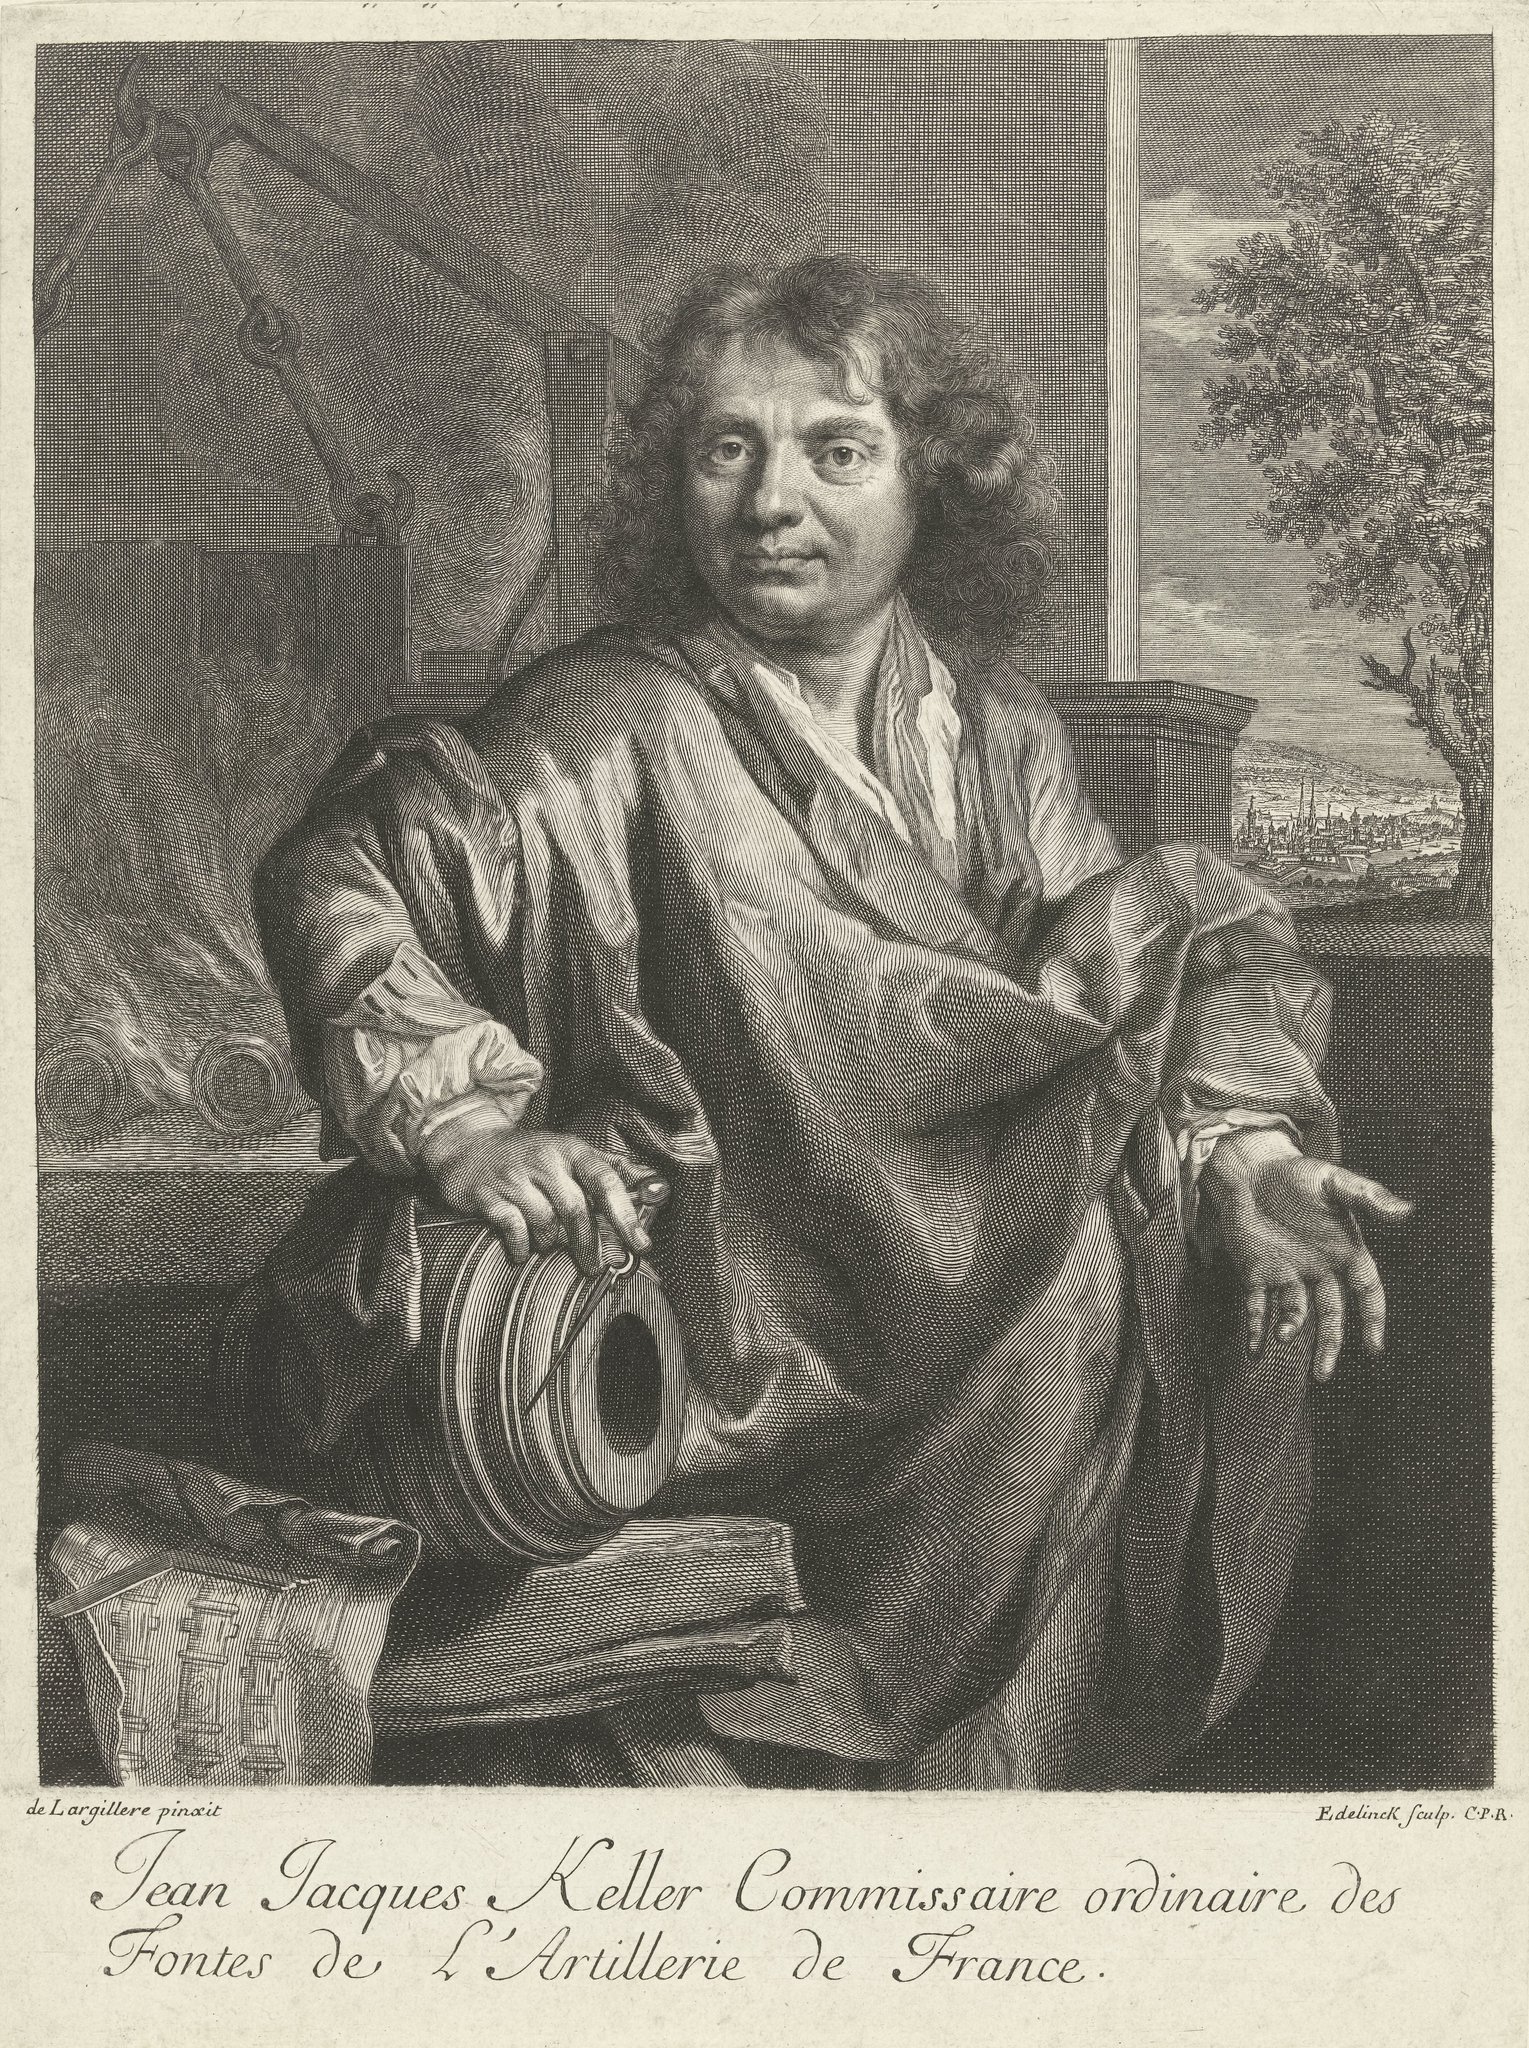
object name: print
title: Portret van Jean-Jacques Keller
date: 1666-1707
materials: paper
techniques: engraving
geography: france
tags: jean-jacques keller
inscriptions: collector's mark: Lugt 240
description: Portret van Jean-Jacques Keller (1635-1700), een Zwitserse kanongieter in dienst van Frankrijk, ten halven lijve afgebeeld in zijn werkplaats met rechter hand op de schietbuis van een kanon.